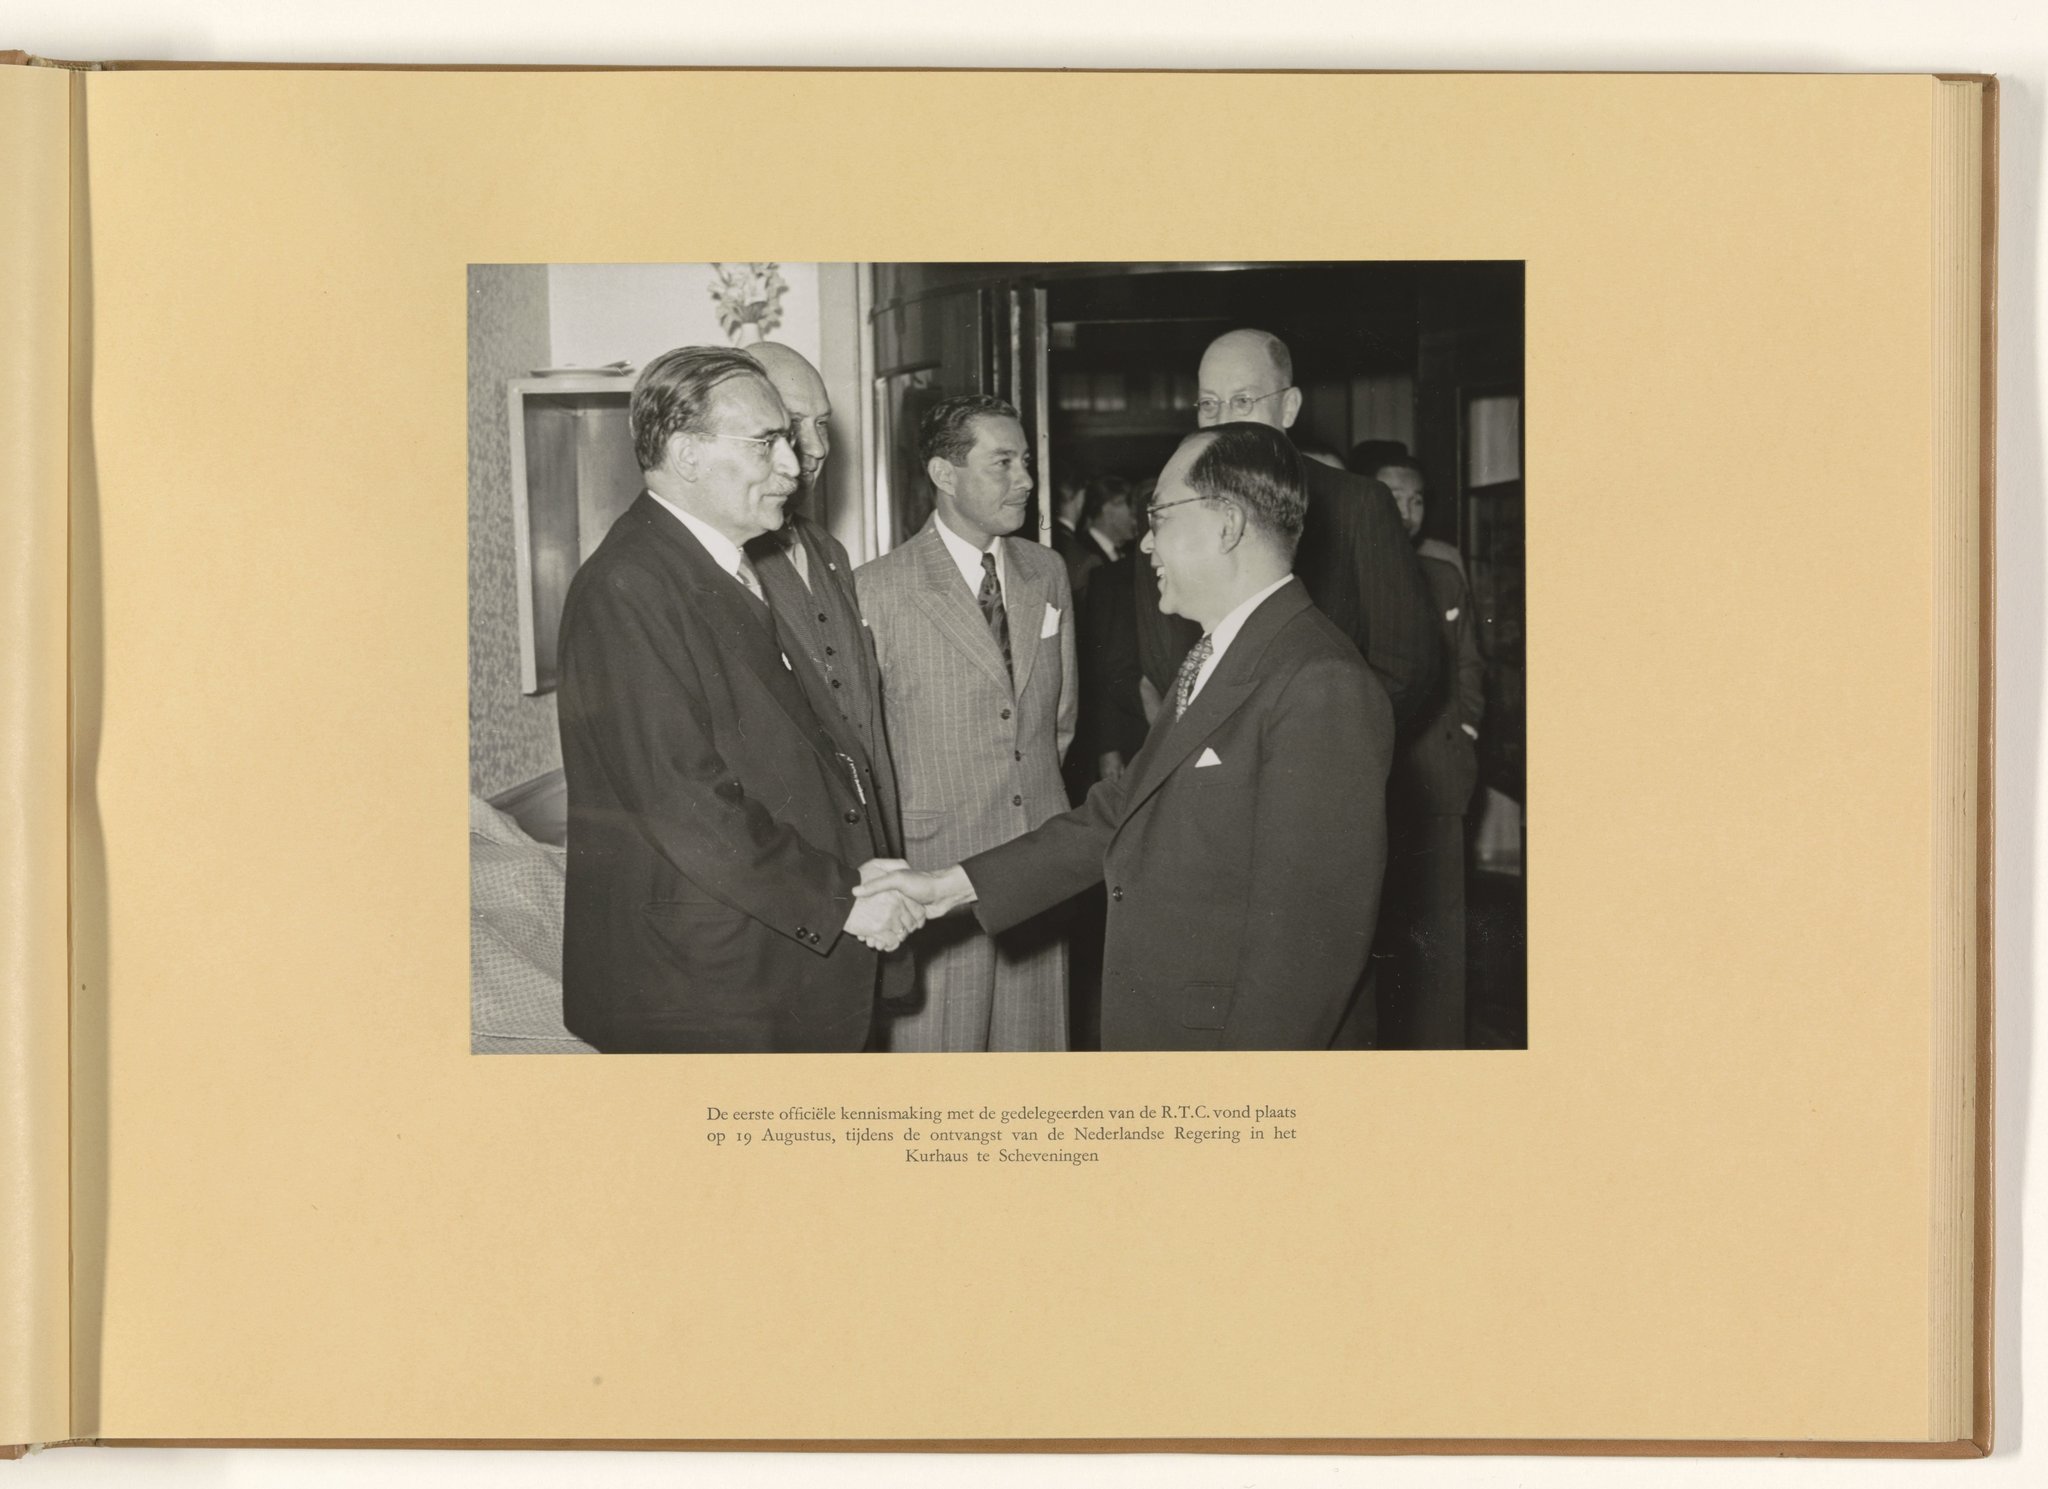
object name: photograph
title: De eerste officiële kennismaking met de gedelegeerden van de R.T.C. vond plaats op 19 Augustus, tijdens de ontvangst van de Nederlandse regering in het Kurhaus te Scheveningen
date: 1949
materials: paper, photographic support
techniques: gelatin silver print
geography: the hague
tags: mohammad hatta, amsterdam, the hague, willem drees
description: Premier Willem Drees verwelkomt de deelnemers aan de conferentie in het Kurhaus te Scheveningen, 19 augustus 1949. Drees schudt Hatta de hand. Foto in het fotoalbum met 37 foto's van de rondetafelconferentie gehouden tussen 23 augustus en 2 november in Den Haag in 1949 tussen vertegenwoordigers van Nederland, de Republiek Indonesië en de Bijeenkomst Federaal Overleg. Het exemplaar aangeboden aan premier Willem Drees.